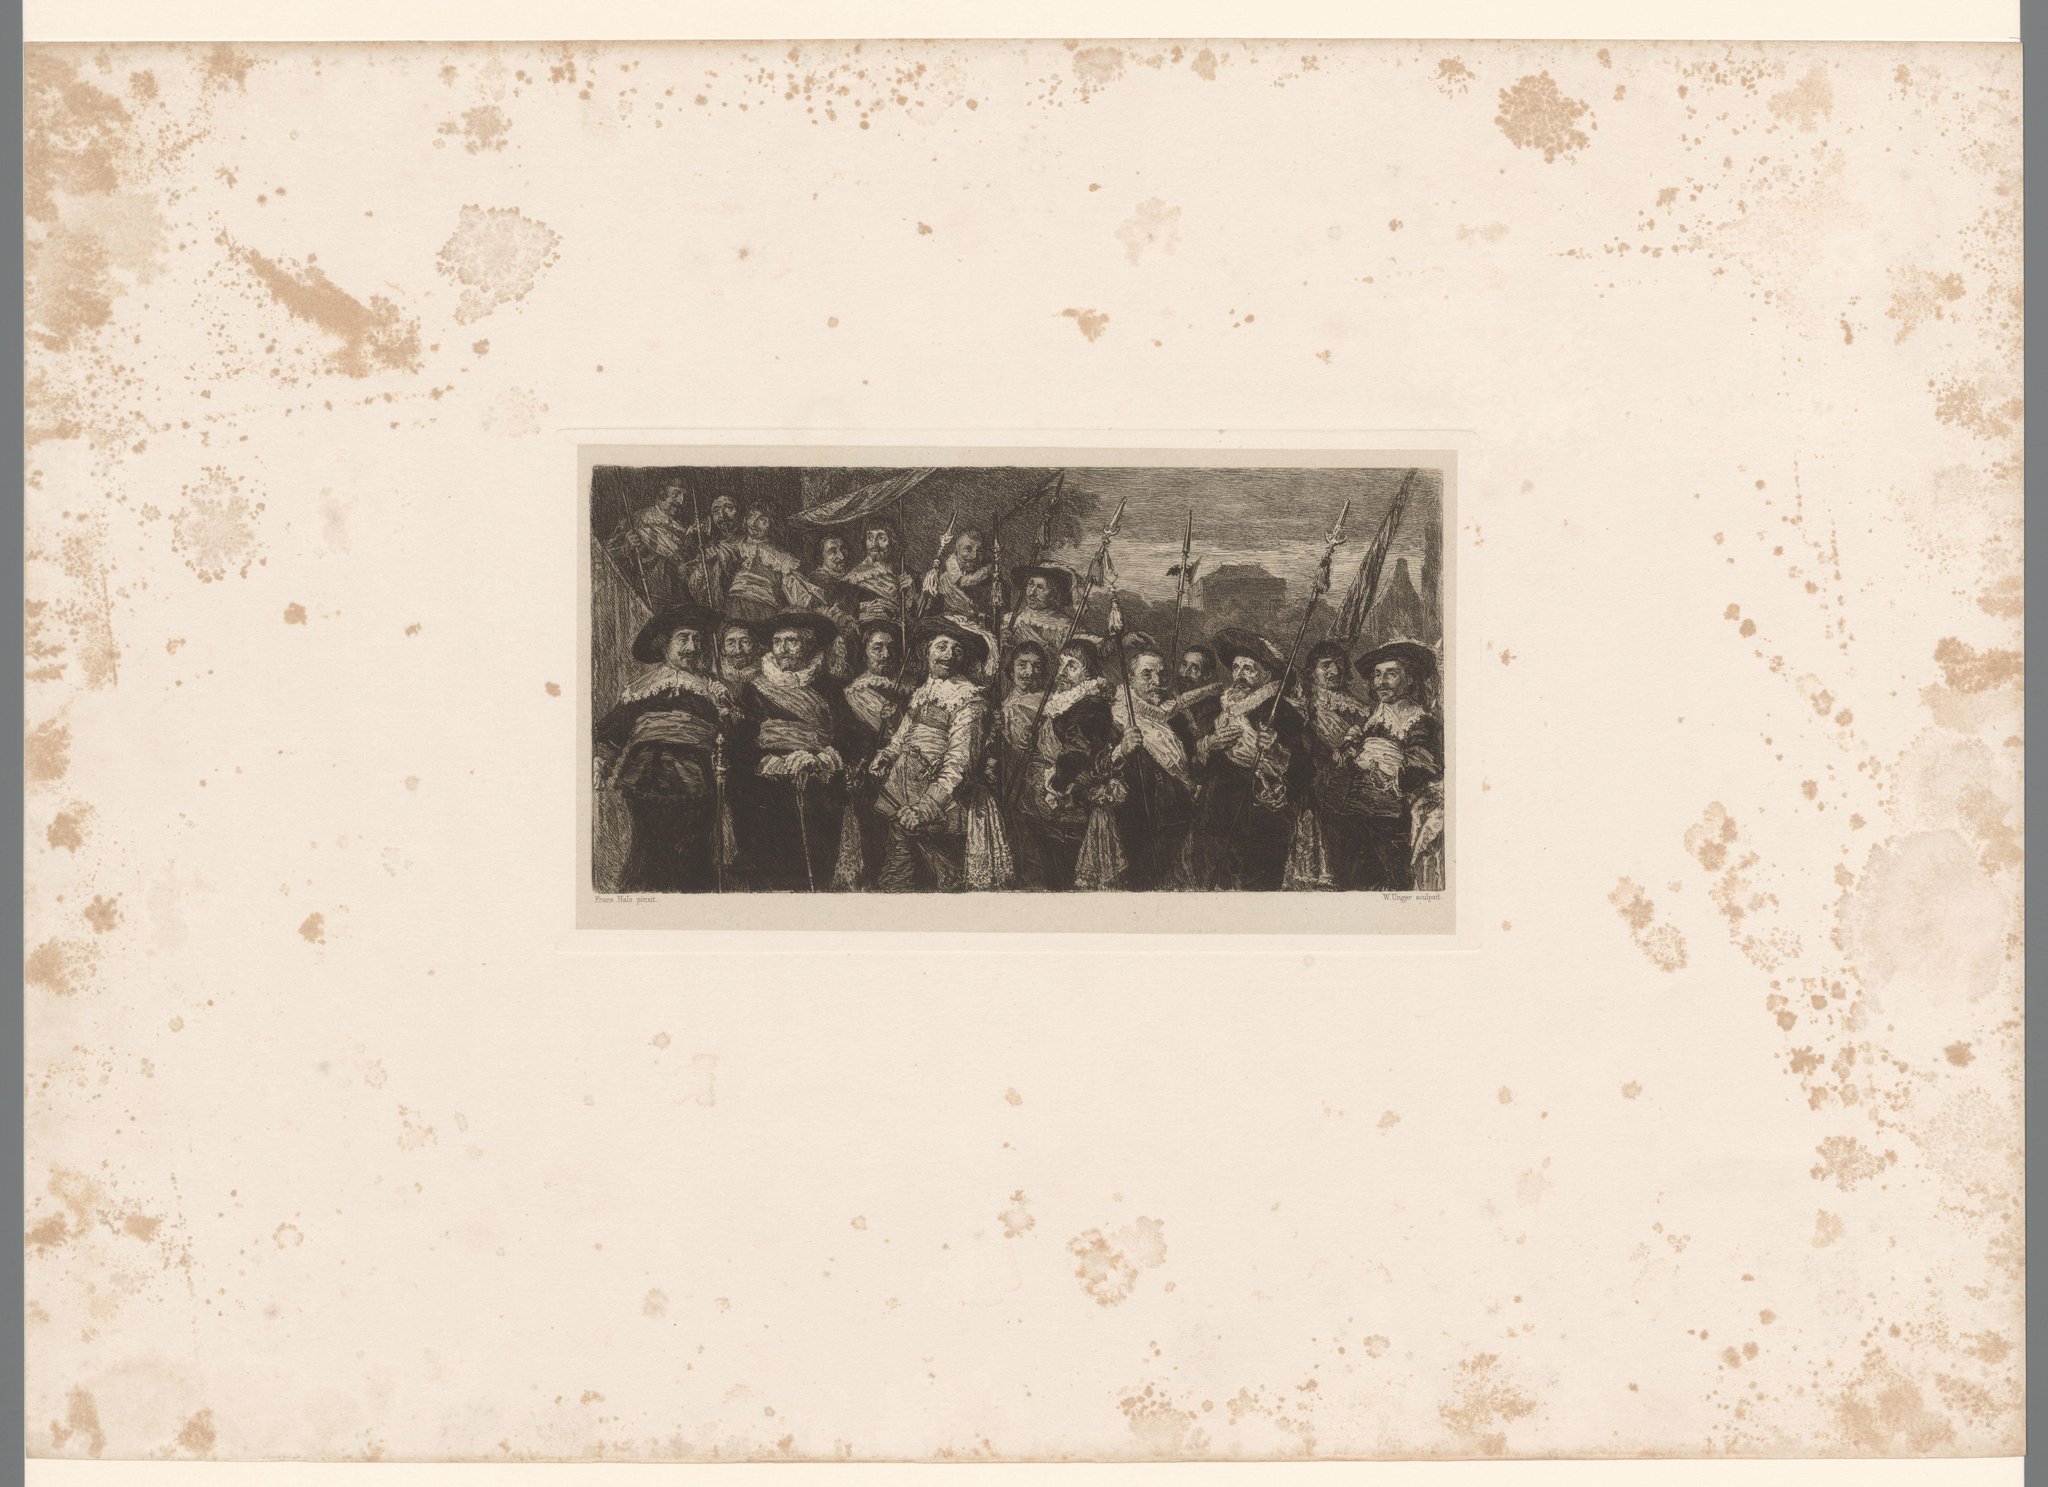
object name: print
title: Officieren en onderofficieren van de Haarlemse Sint Jorisschutterij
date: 1847-1889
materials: paper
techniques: etching, intaglio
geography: haarlem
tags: mayor, delft, antwerp, haarlem, draughtsman, frans hals, amsterdam, painter, hendrik gerritsz pot, (military) standard-bearer, warfare; military affairs (+ citizen soldiery, civil guard, citizen militia), historical persons (portraits and scenes from the life)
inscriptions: collector's mark: Lugt 2228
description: Prent naar het schilderij door Frans Hals in het Frans Halsmuseum te Haarlem (inv.nr. os I-113).